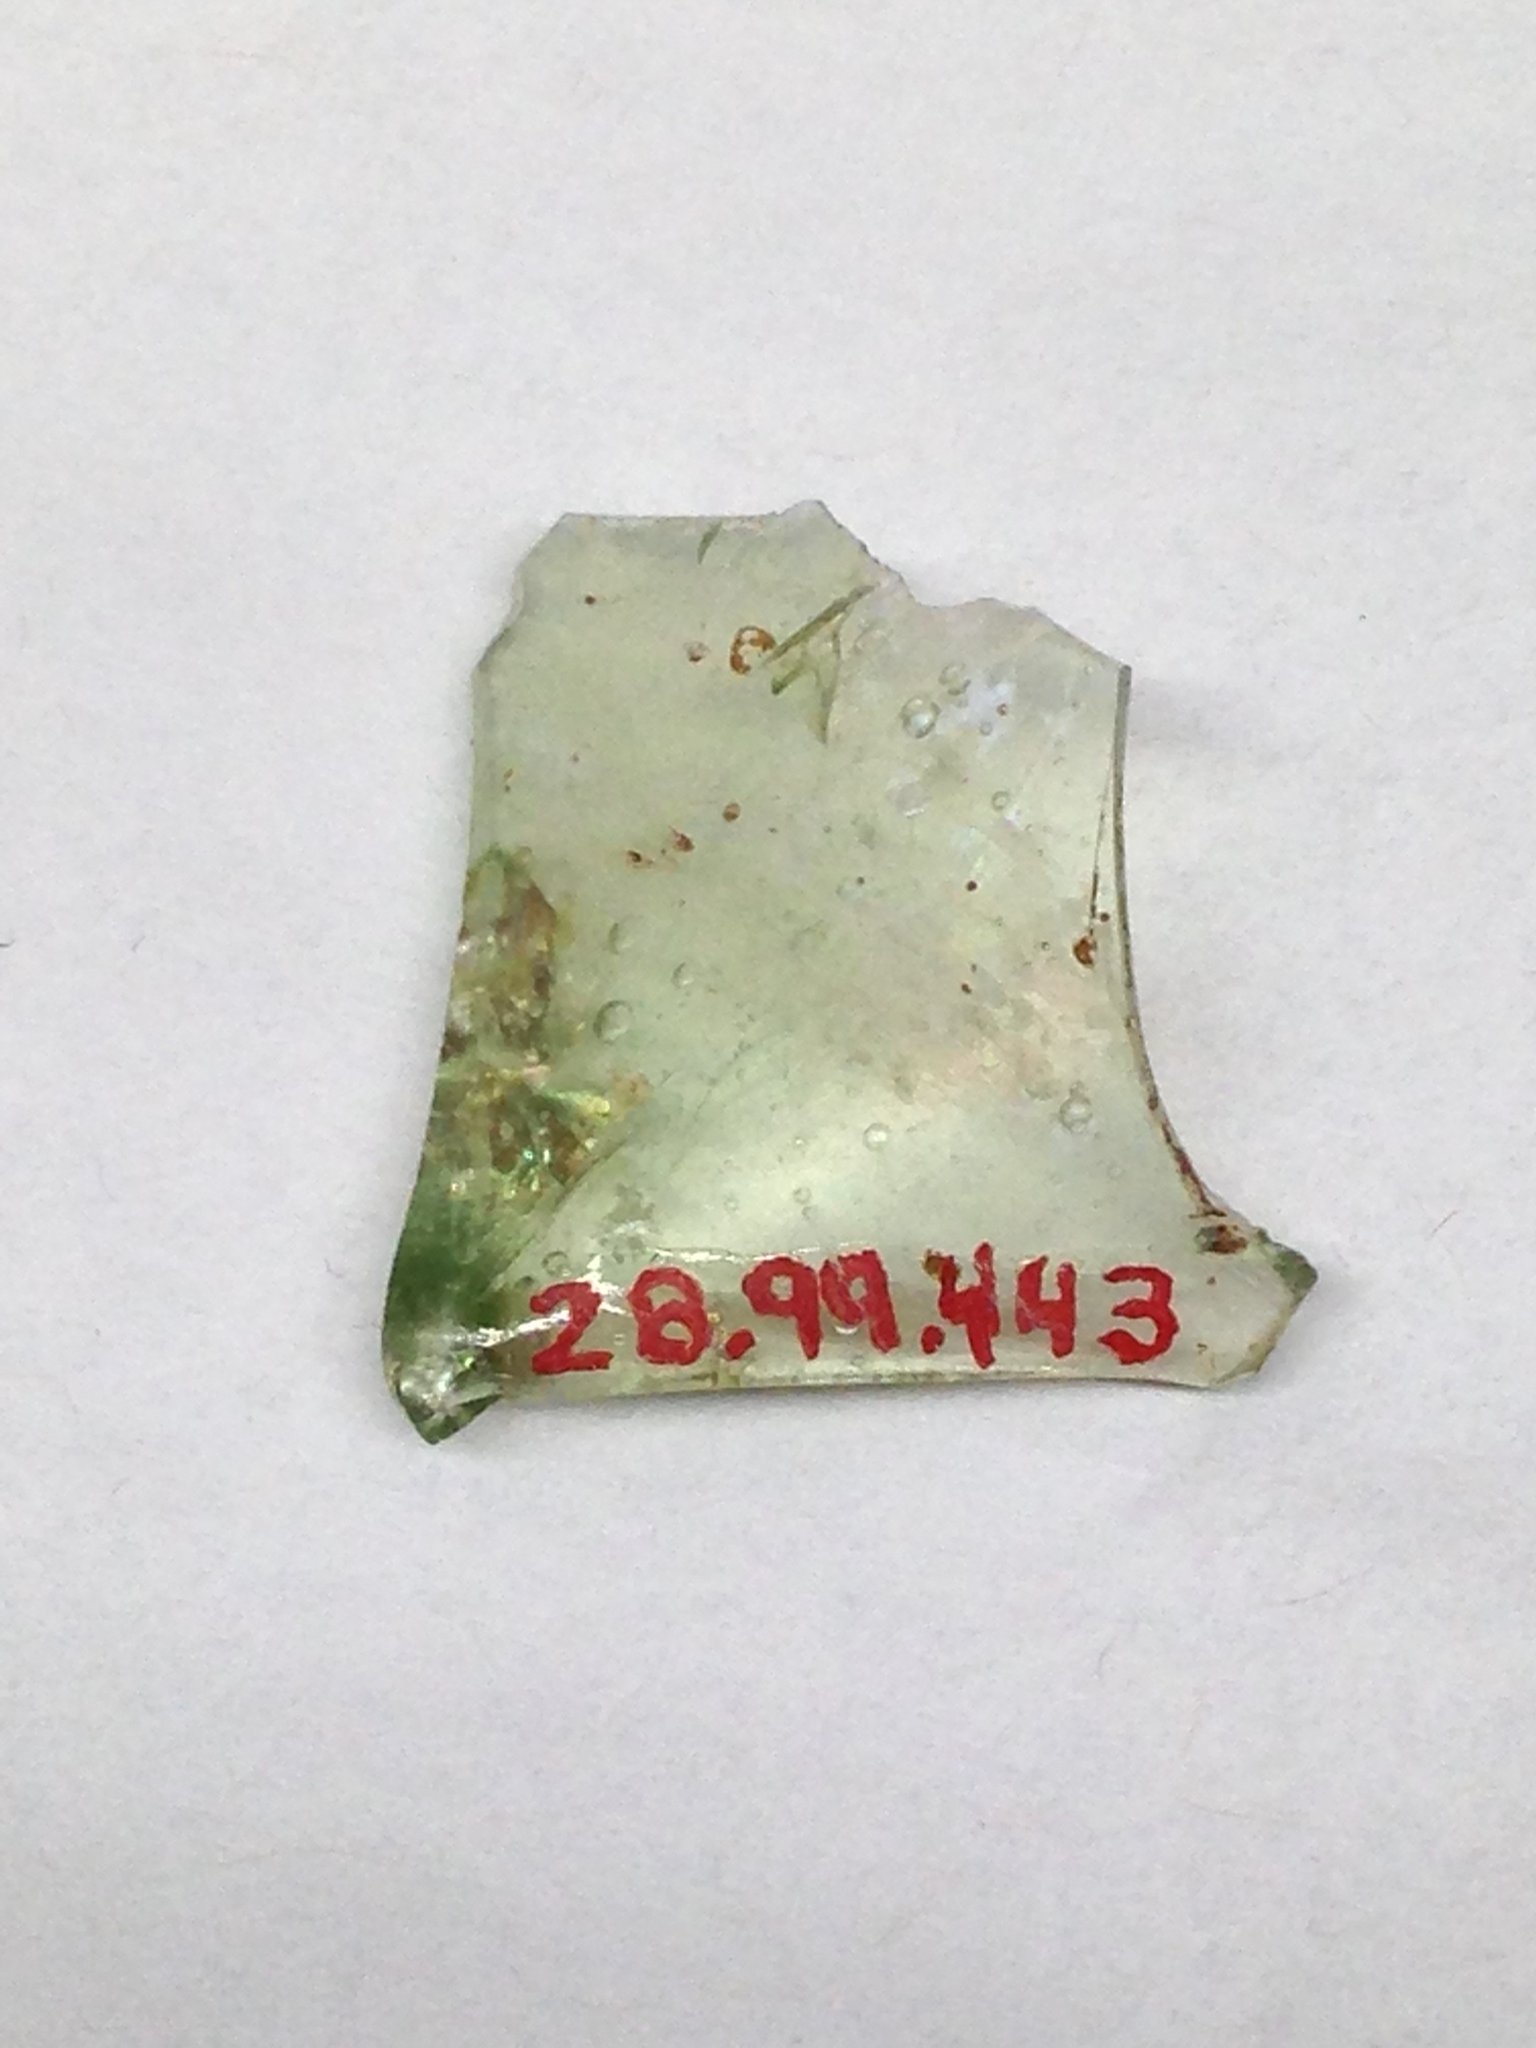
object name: fragment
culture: european or middle eastern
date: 1150-1250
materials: ceramic, glass